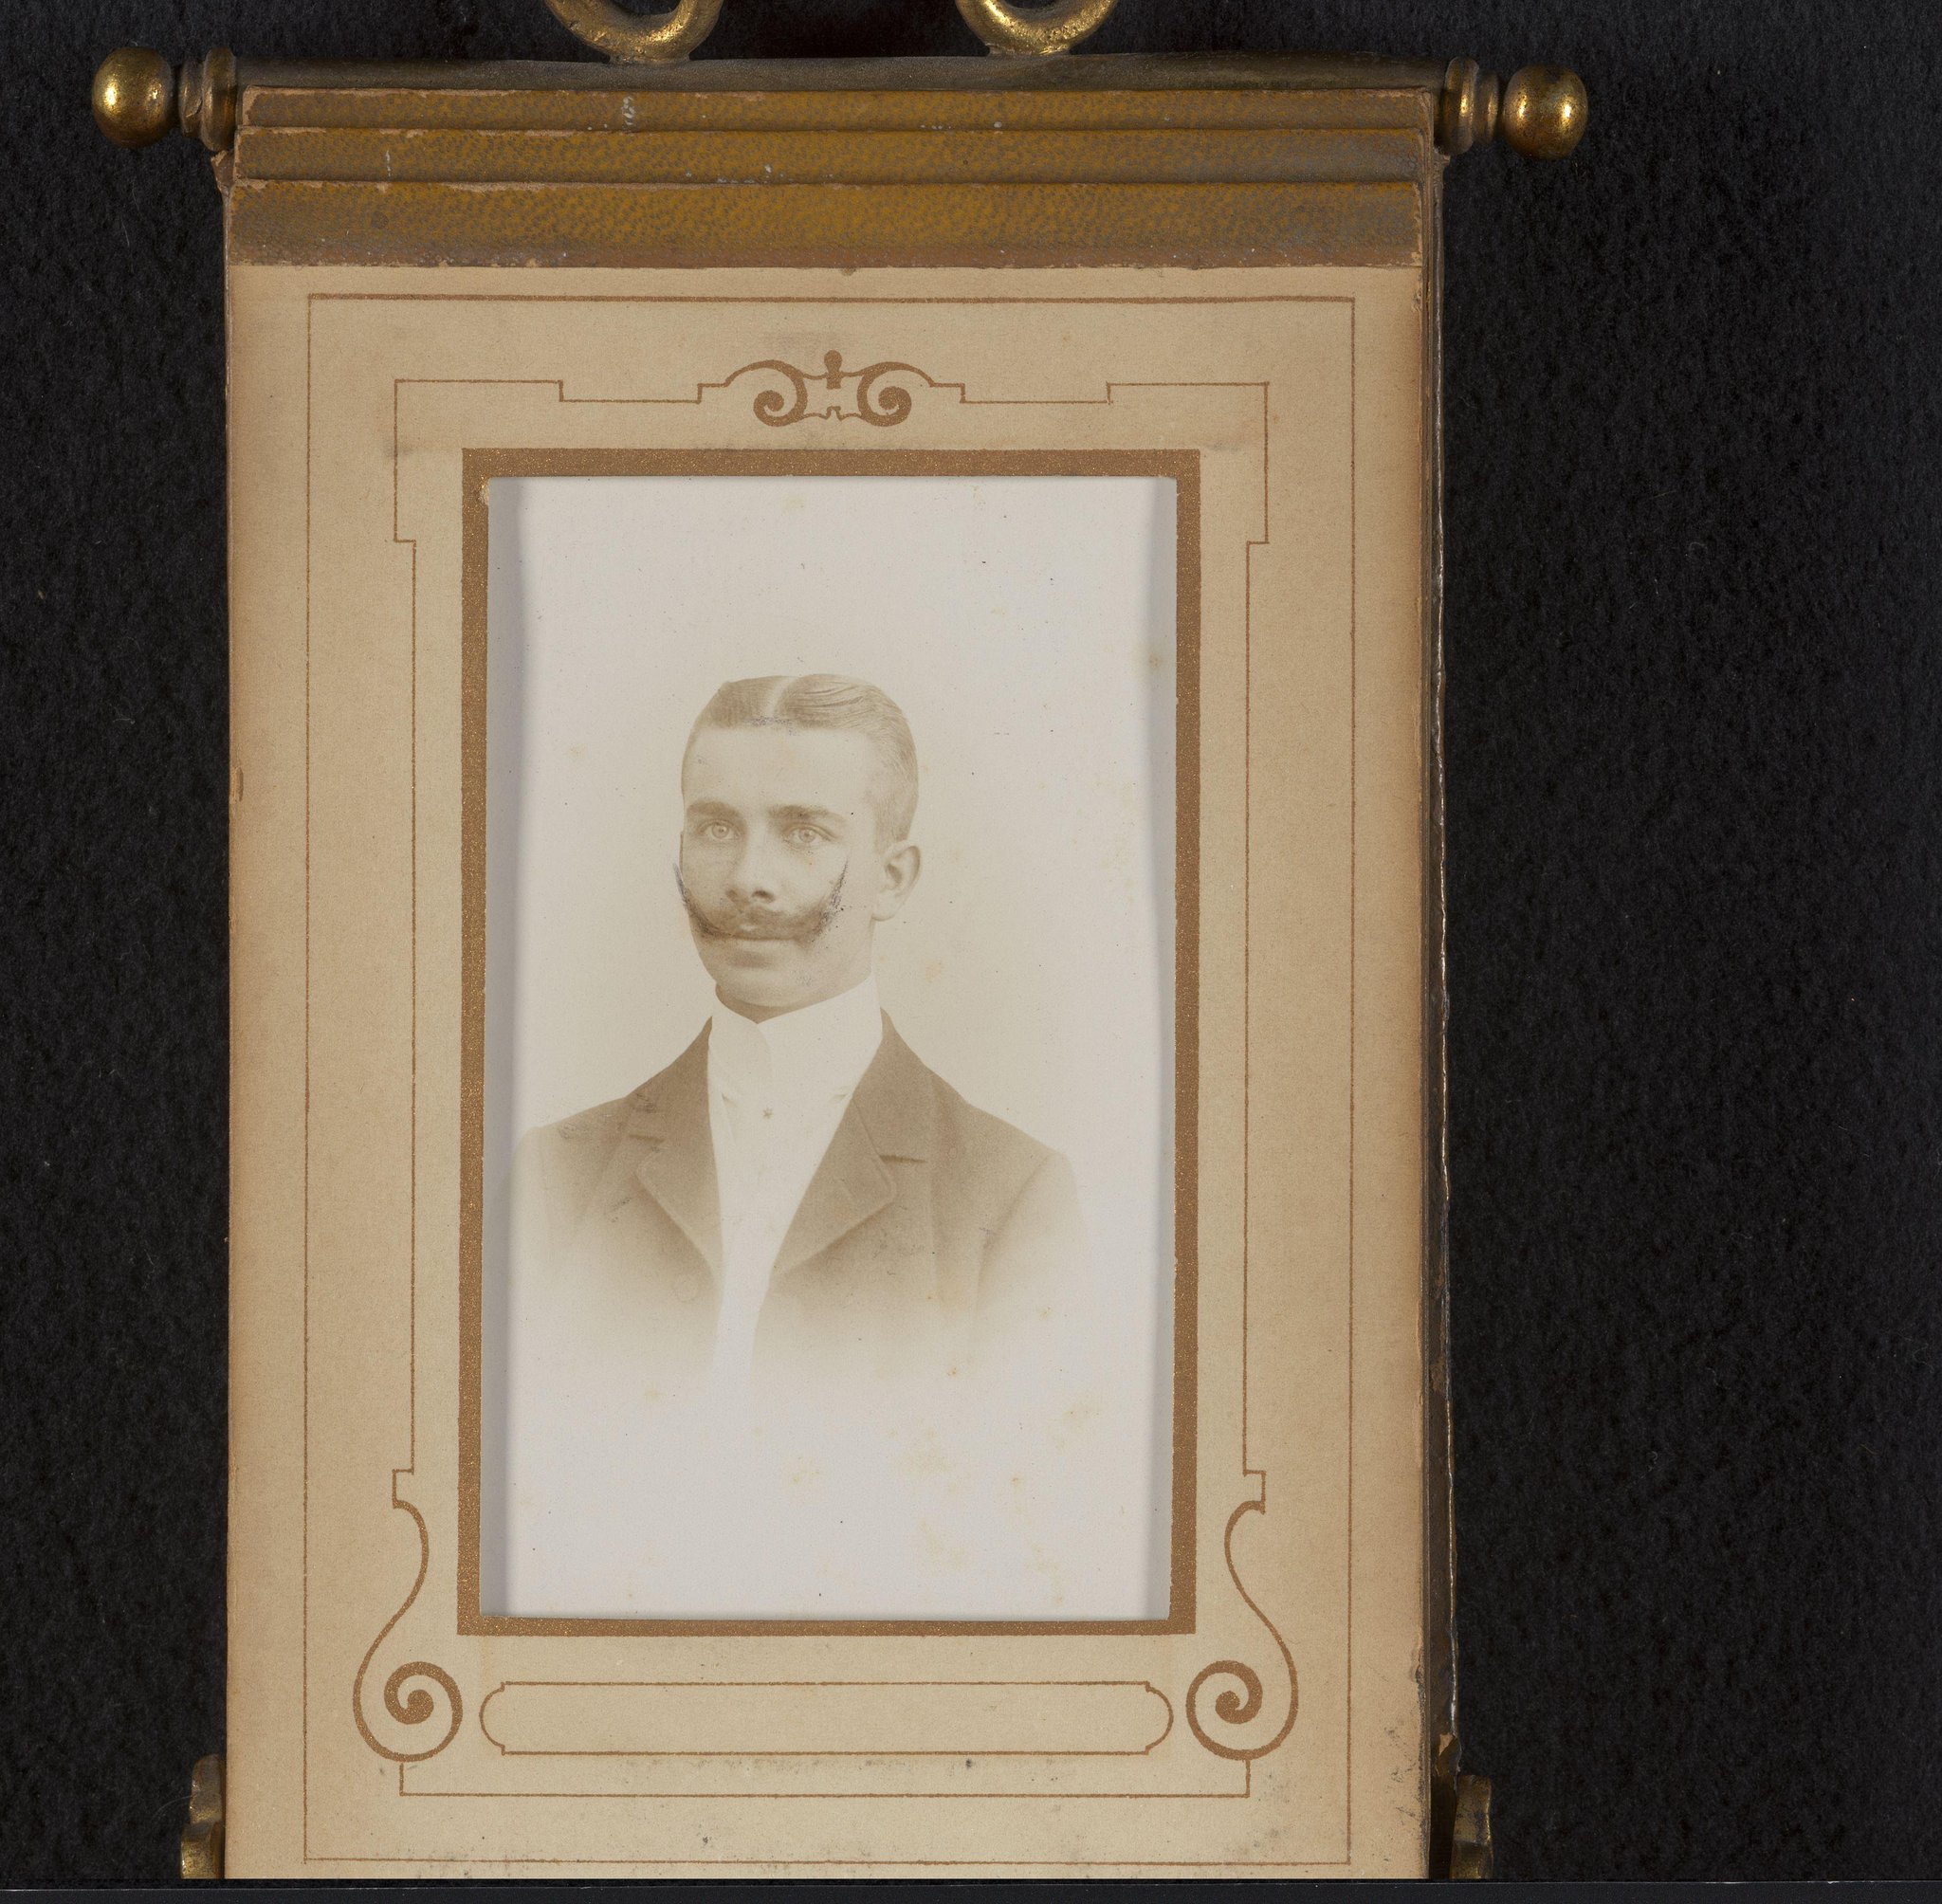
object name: photograph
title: Portret van een man met snor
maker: eduard glaubach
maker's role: fotograaf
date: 1901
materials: cardboard, photographic support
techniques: collodion silver print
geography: greifswald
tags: moustache, historical persons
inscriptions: inscription: ‘E. Glaubach Nach[...]/ TH. WULFF Photograph. Atelier/ Greifswald/ 4, Lange-Str. 4./ Die Platten bleiben für Nachbestellungen/ und Vergrösserungen aufbewahrt./ Das Atelier ist täglich, auch Sonntags geöfnnet’, annotation: ‘[....]/ Kohlmann z. fr. Eug./ Greifswald. 1901.’